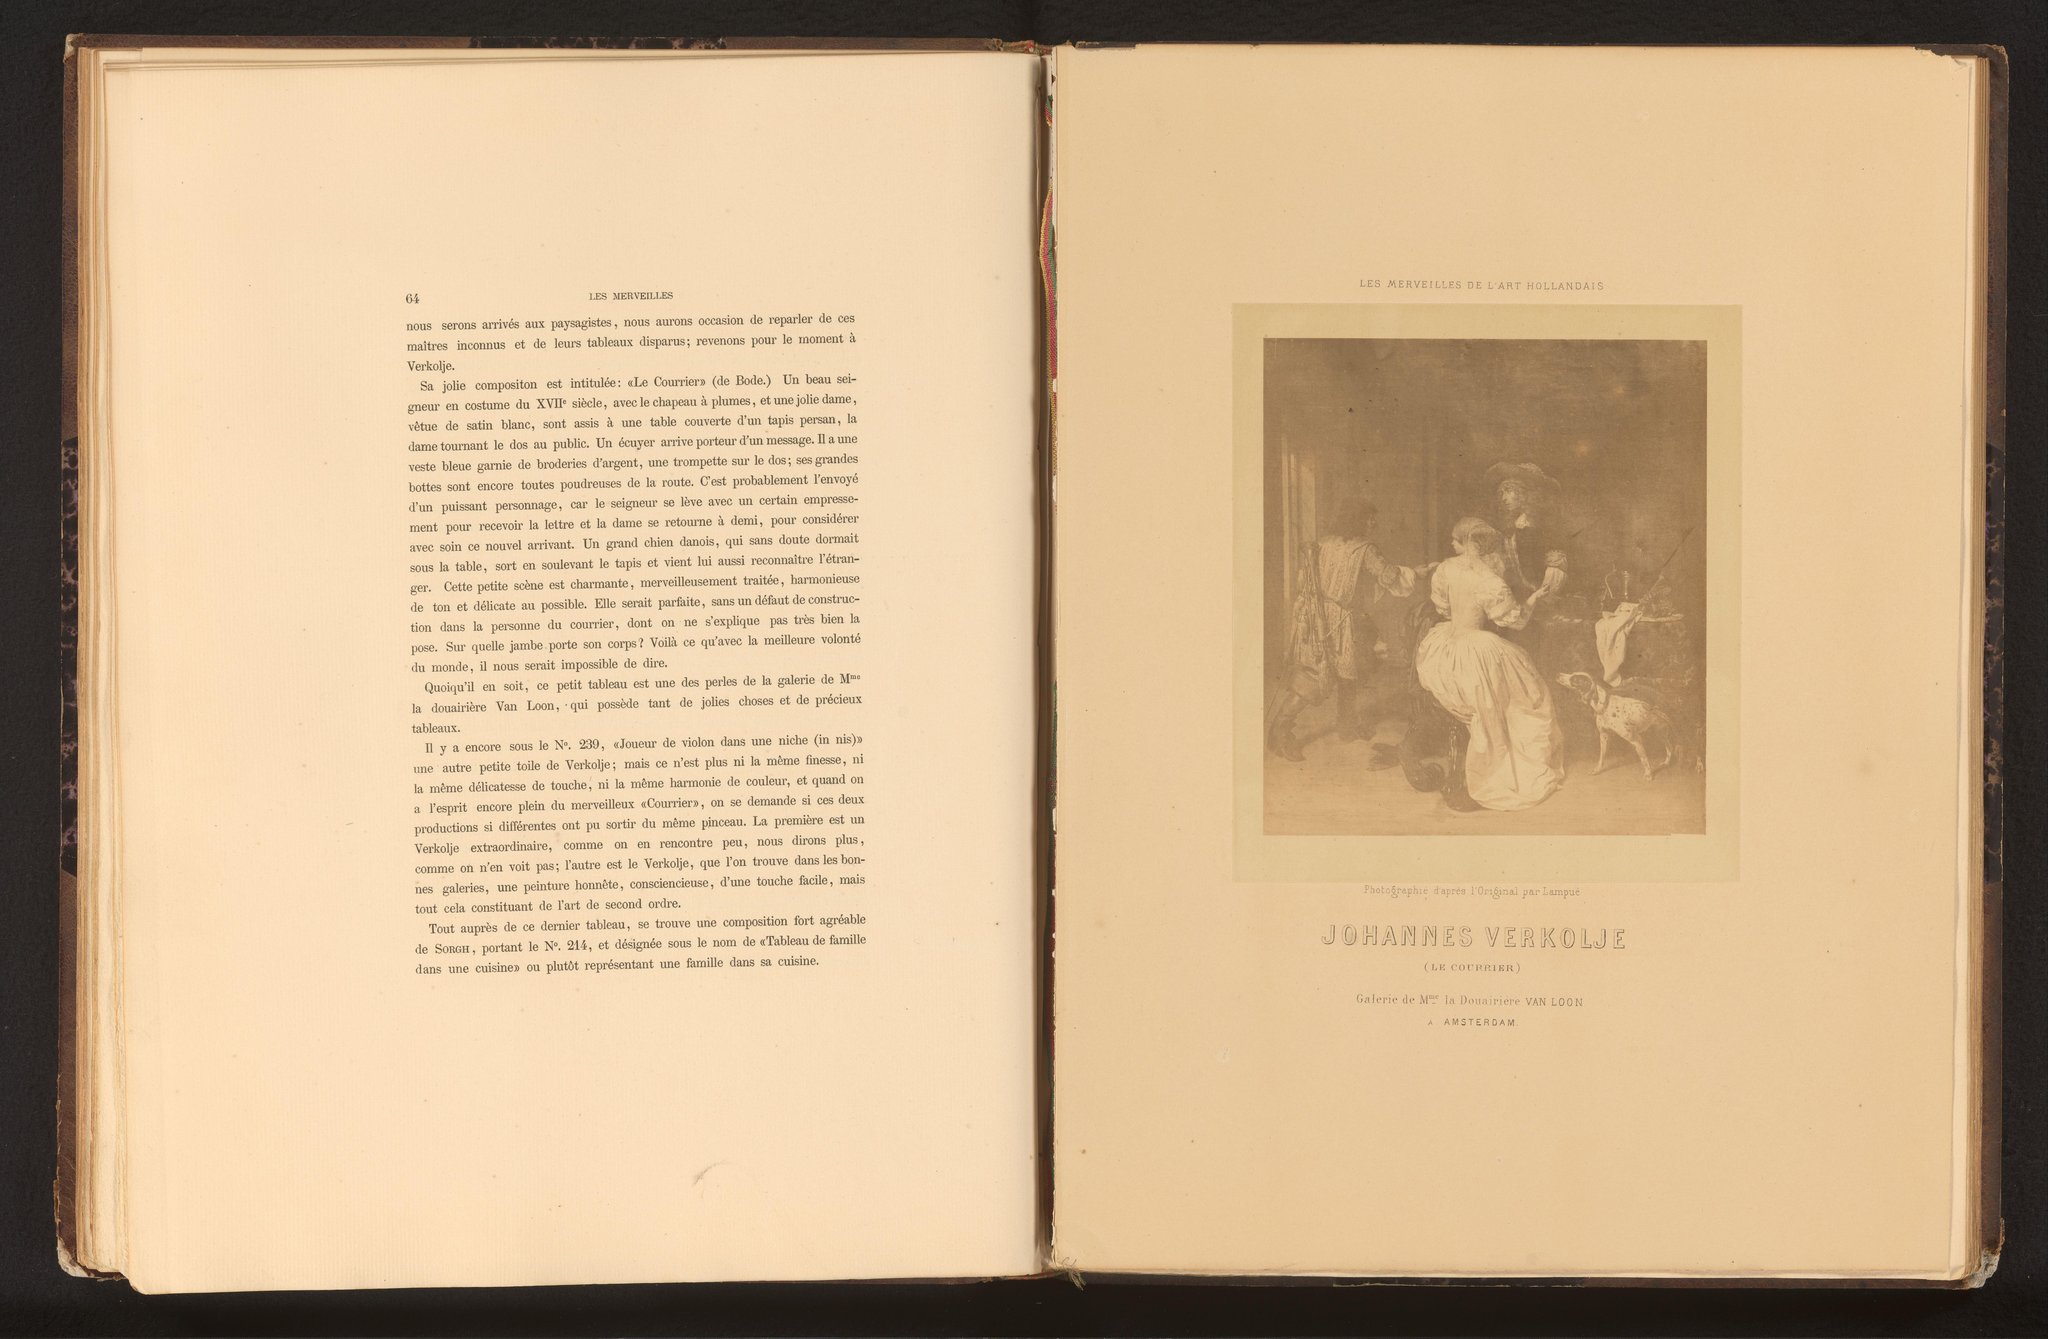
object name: reproduction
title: Fotoreproductie van het schilderij 'De boodschapper' door Johannes Verkolje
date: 1867-1872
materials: paper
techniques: woodburytype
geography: amsterdam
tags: messenger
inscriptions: inscription: ‘Galerie de Mme la Douairière VAN LOON/ à AMSTERDAM’